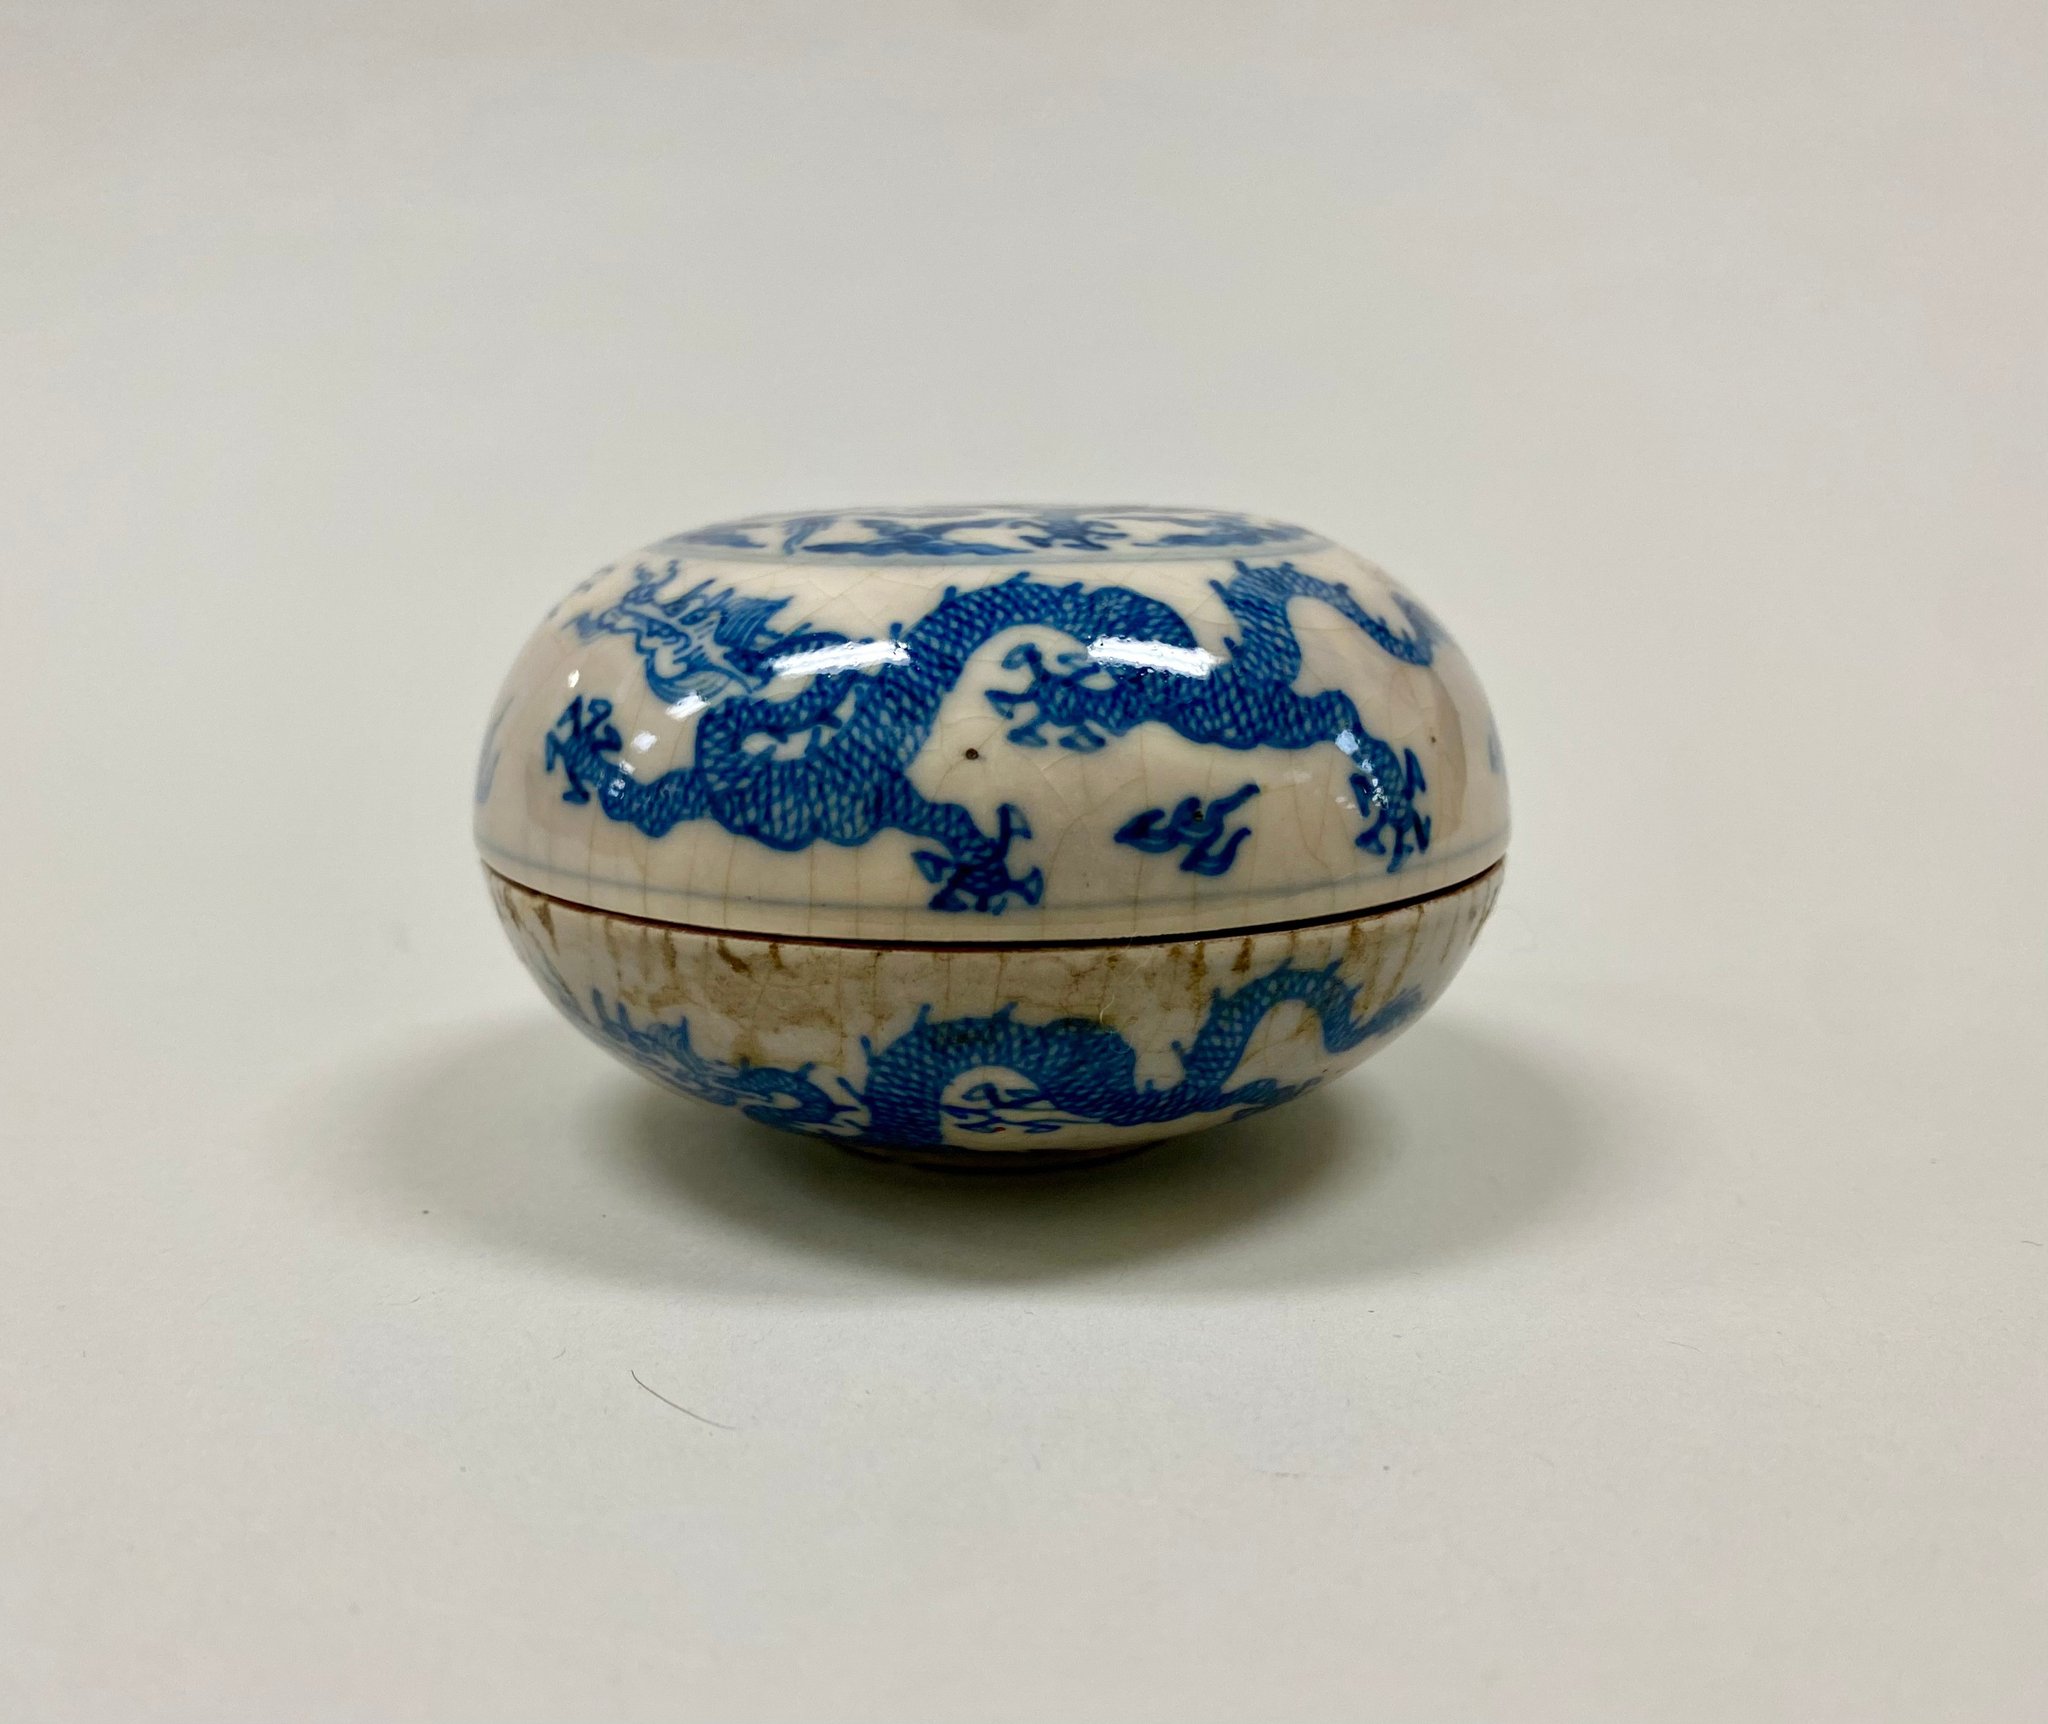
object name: seal paste box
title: Seal paste box with dragons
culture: chinese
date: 1701-1733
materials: cobalt, soft paste porcelain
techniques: painting, underglaze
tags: dragons